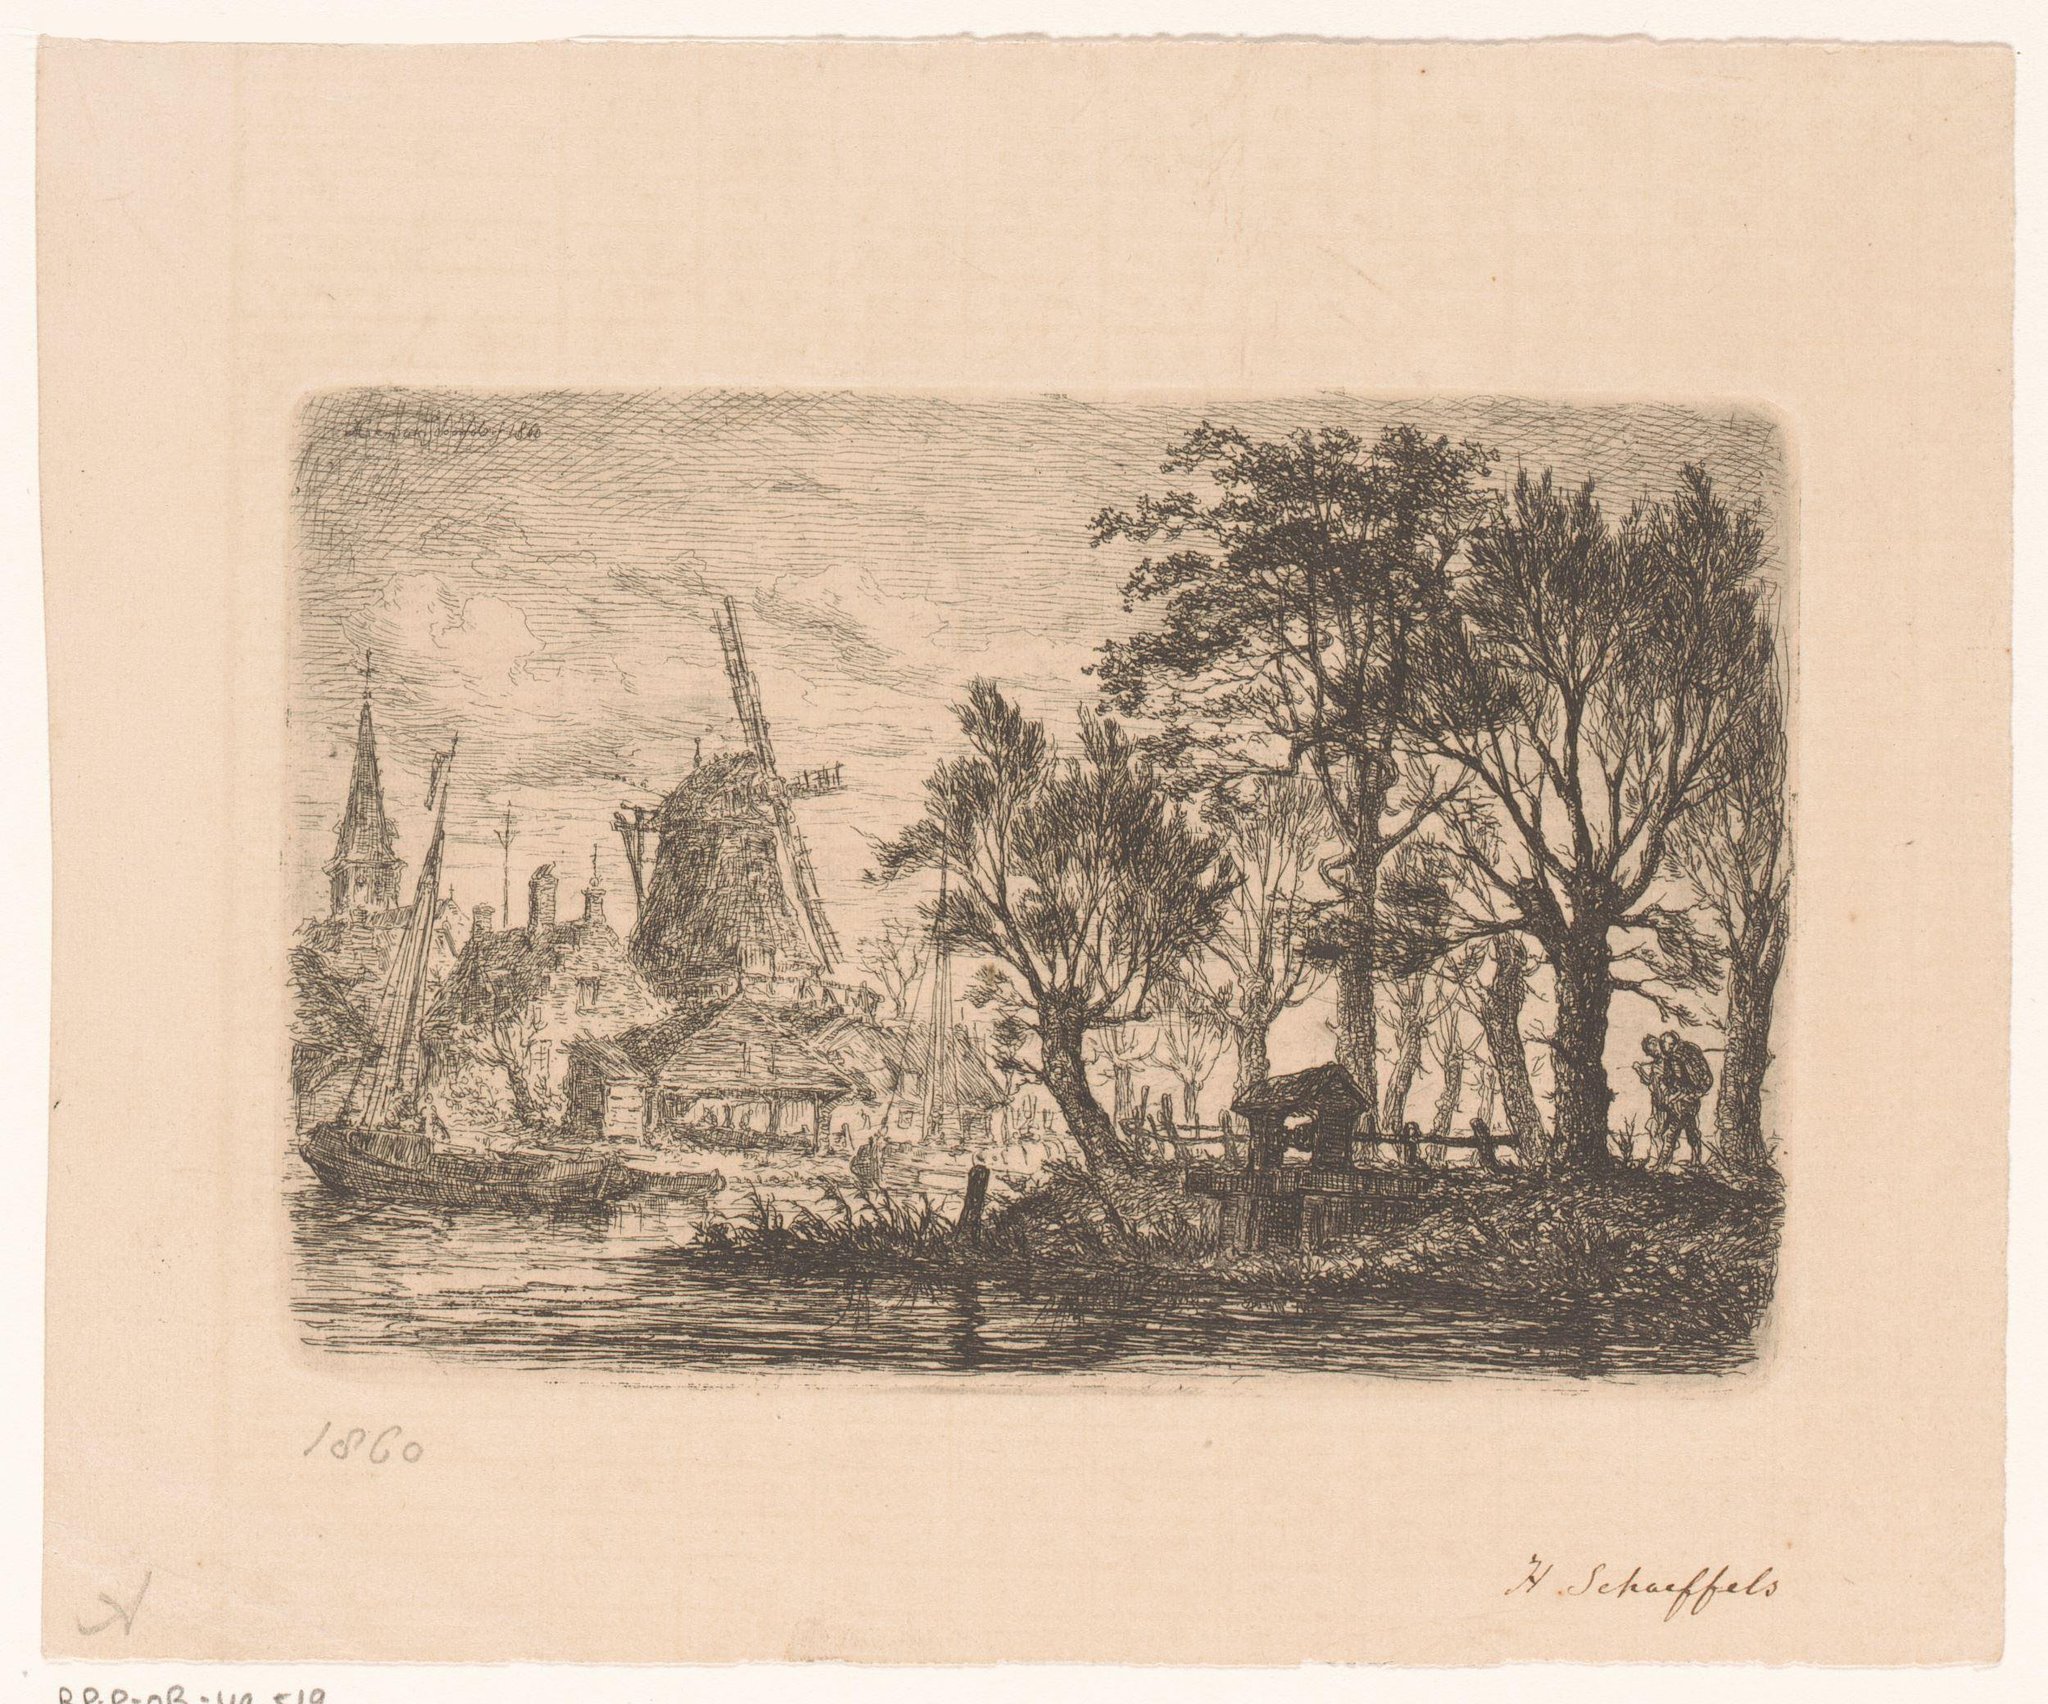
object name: print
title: Gezicht op een dorp met molen aan het water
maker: henri françois schaefels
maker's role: print maker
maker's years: 1827-1904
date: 1860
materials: paper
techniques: etching, letterpress printing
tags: water course, village, windmill in landscape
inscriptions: collector's mark: Lugt 2228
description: Op verso tabel met getallen en plaatsnamen.